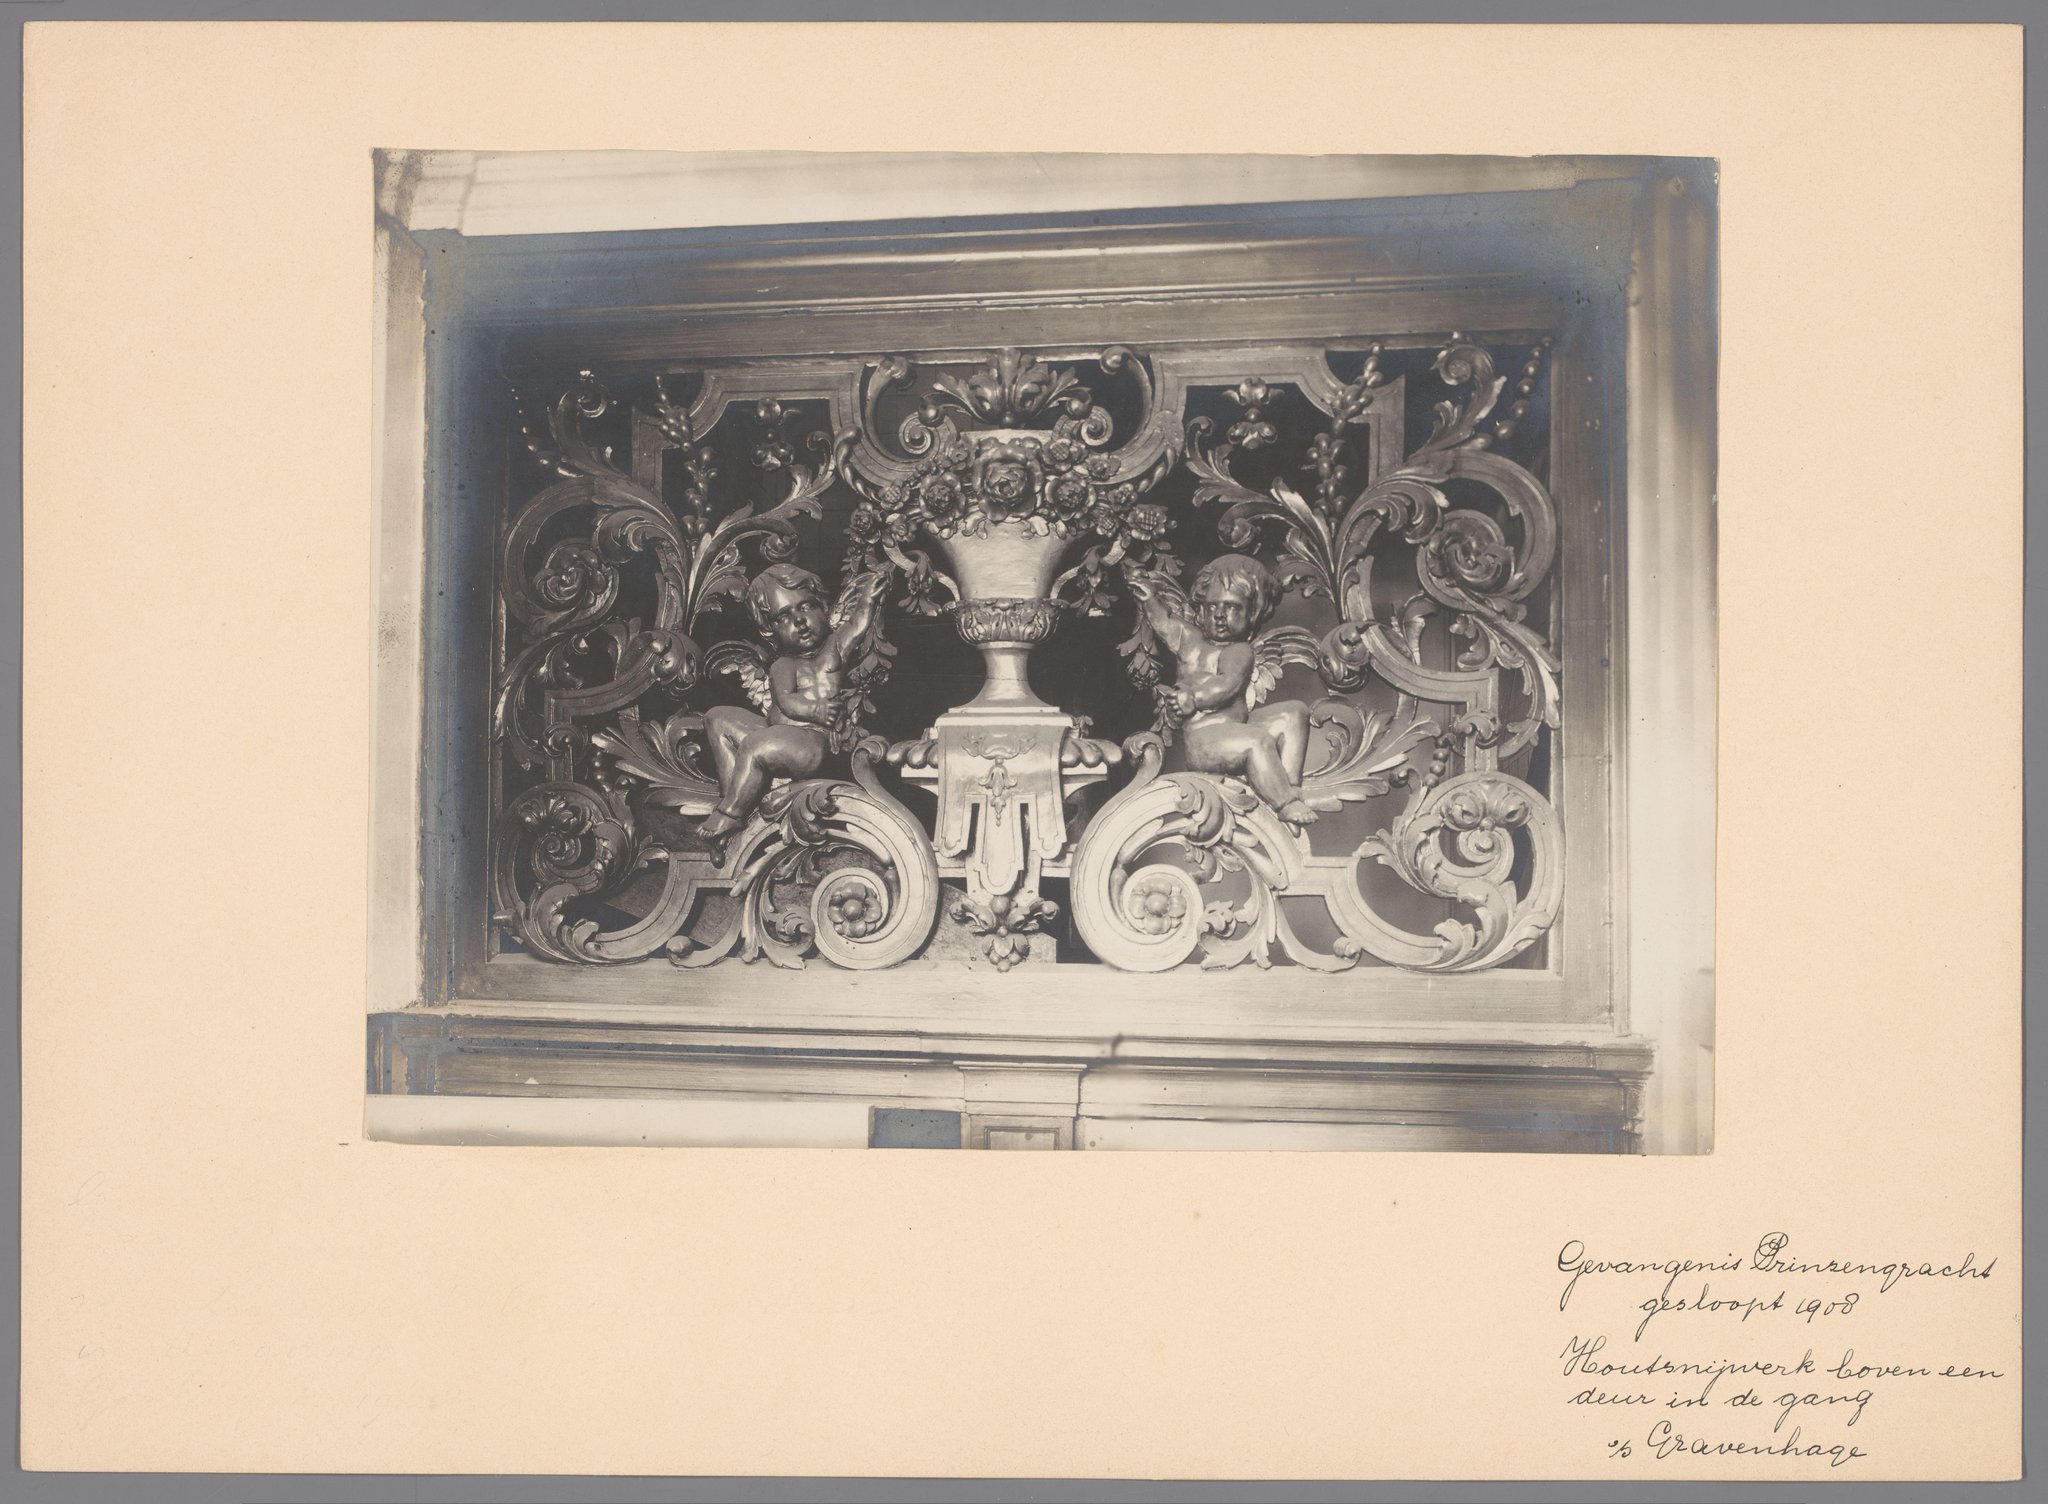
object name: photograph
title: Houtsnijwerk boven een deur in de gevangenis op de Prinsegracht te Den Haag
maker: anoniem (monumentenzorg)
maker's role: fotograaf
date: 1900-1908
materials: cardboard, photographic support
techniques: gelatin silver print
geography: prinsegracht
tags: prison, jail, door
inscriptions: collector's mark: ‘R:MUS.’ Lugt 2228, annotation: ‘Gevangenis Prinsengracht gesloopt 1908/ Houtsnijwerk boven een deur in de gang/ 's Gravenhage’